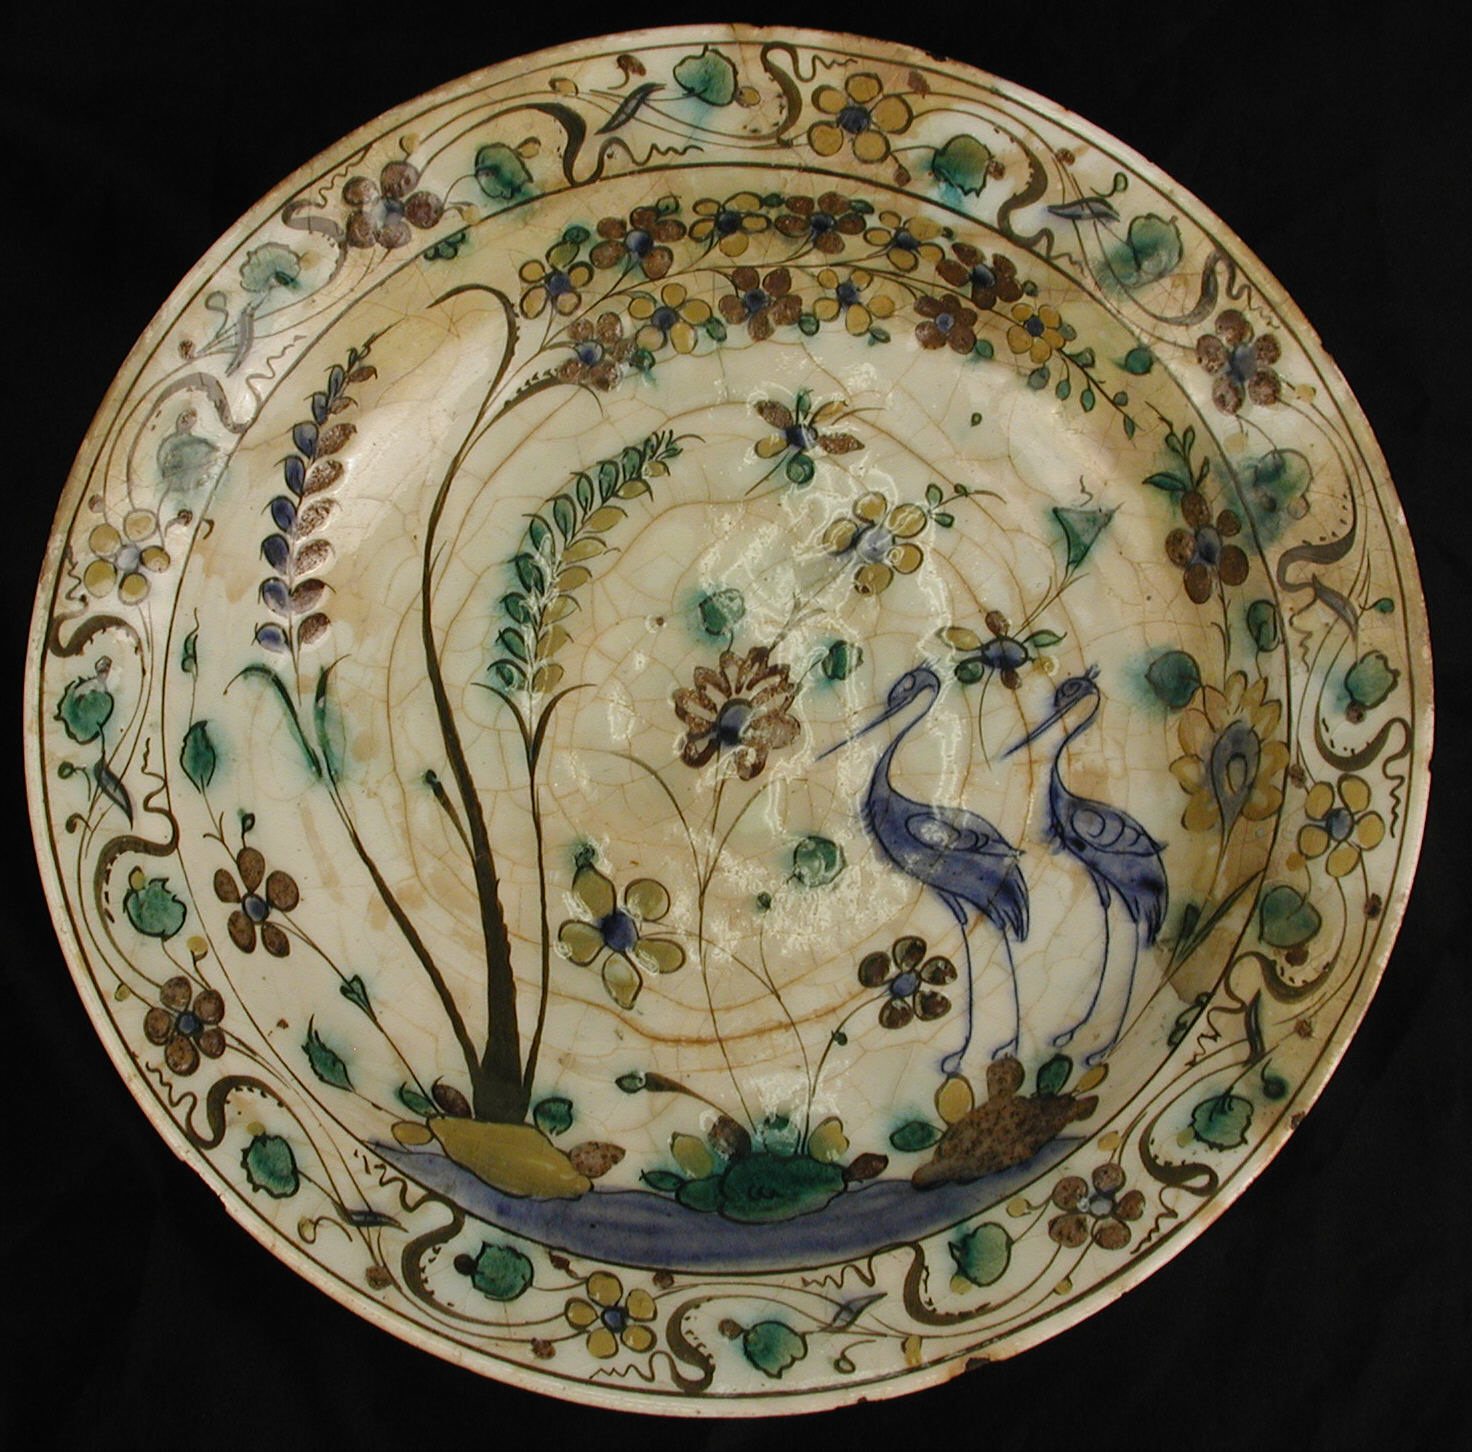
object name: dish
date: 1601-1650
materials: stonepaste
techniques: painting, underglaze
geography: iran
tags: cranes,flowers,leaves